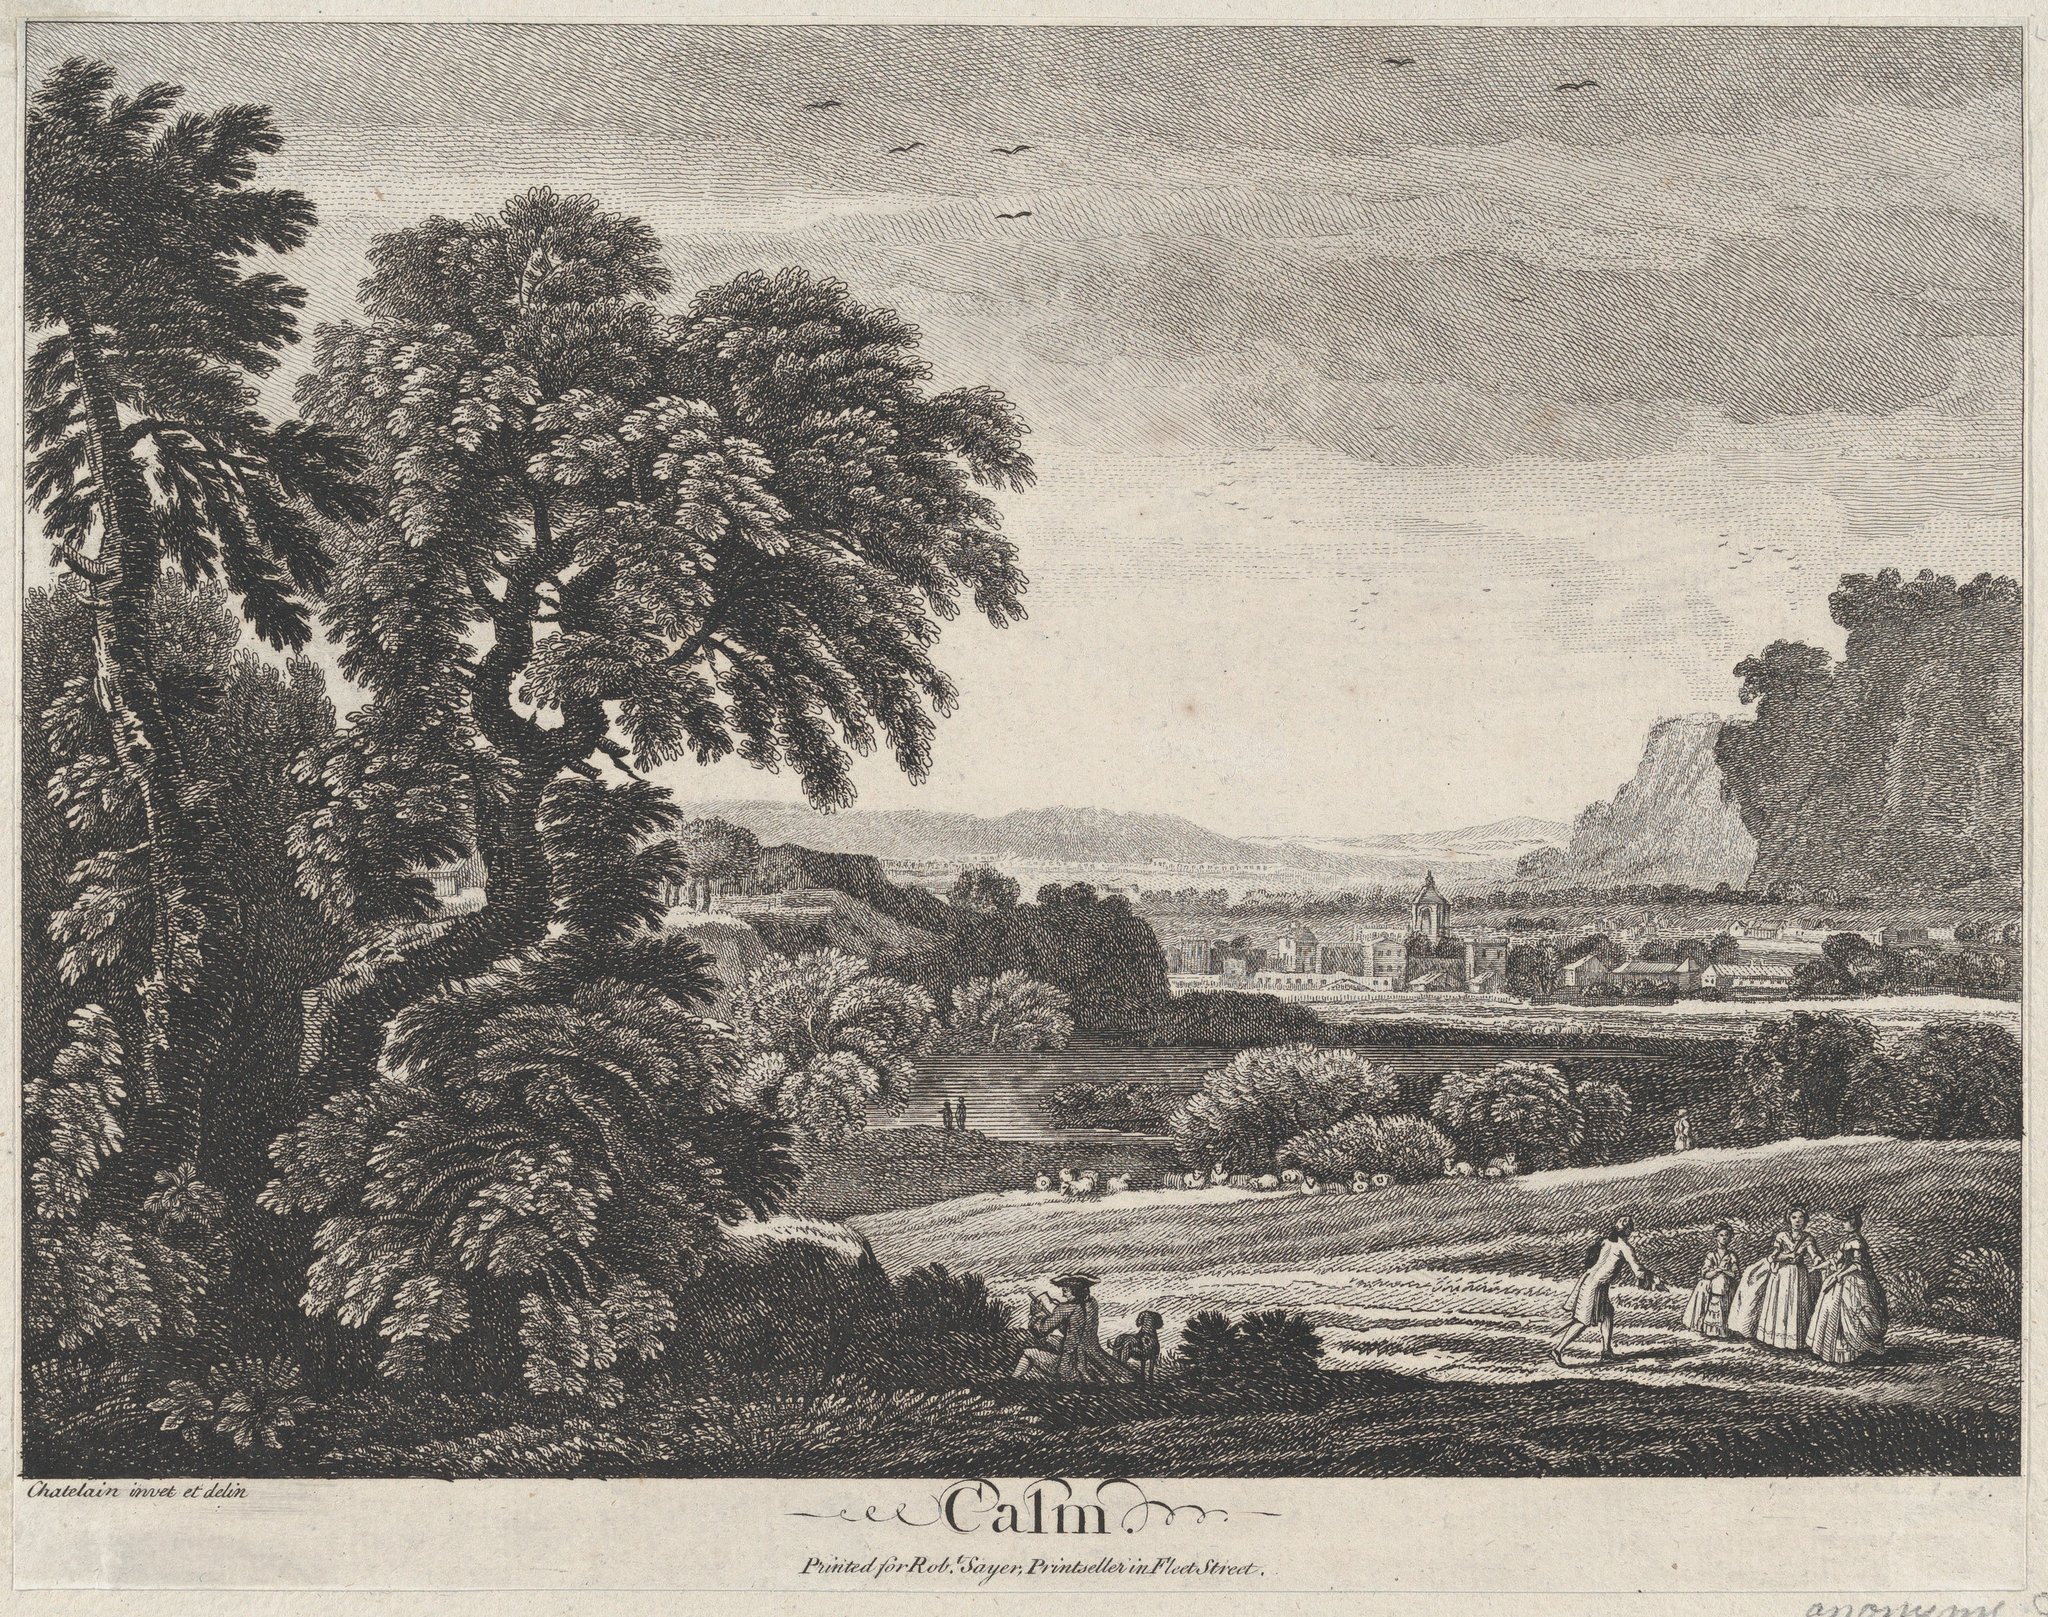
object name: print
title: Calm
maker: jean-baptiste-claude chatelain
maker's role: artist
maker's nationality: british, french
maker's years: 1705-1758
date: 1745-1758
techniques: etching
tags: men,women,landscapes